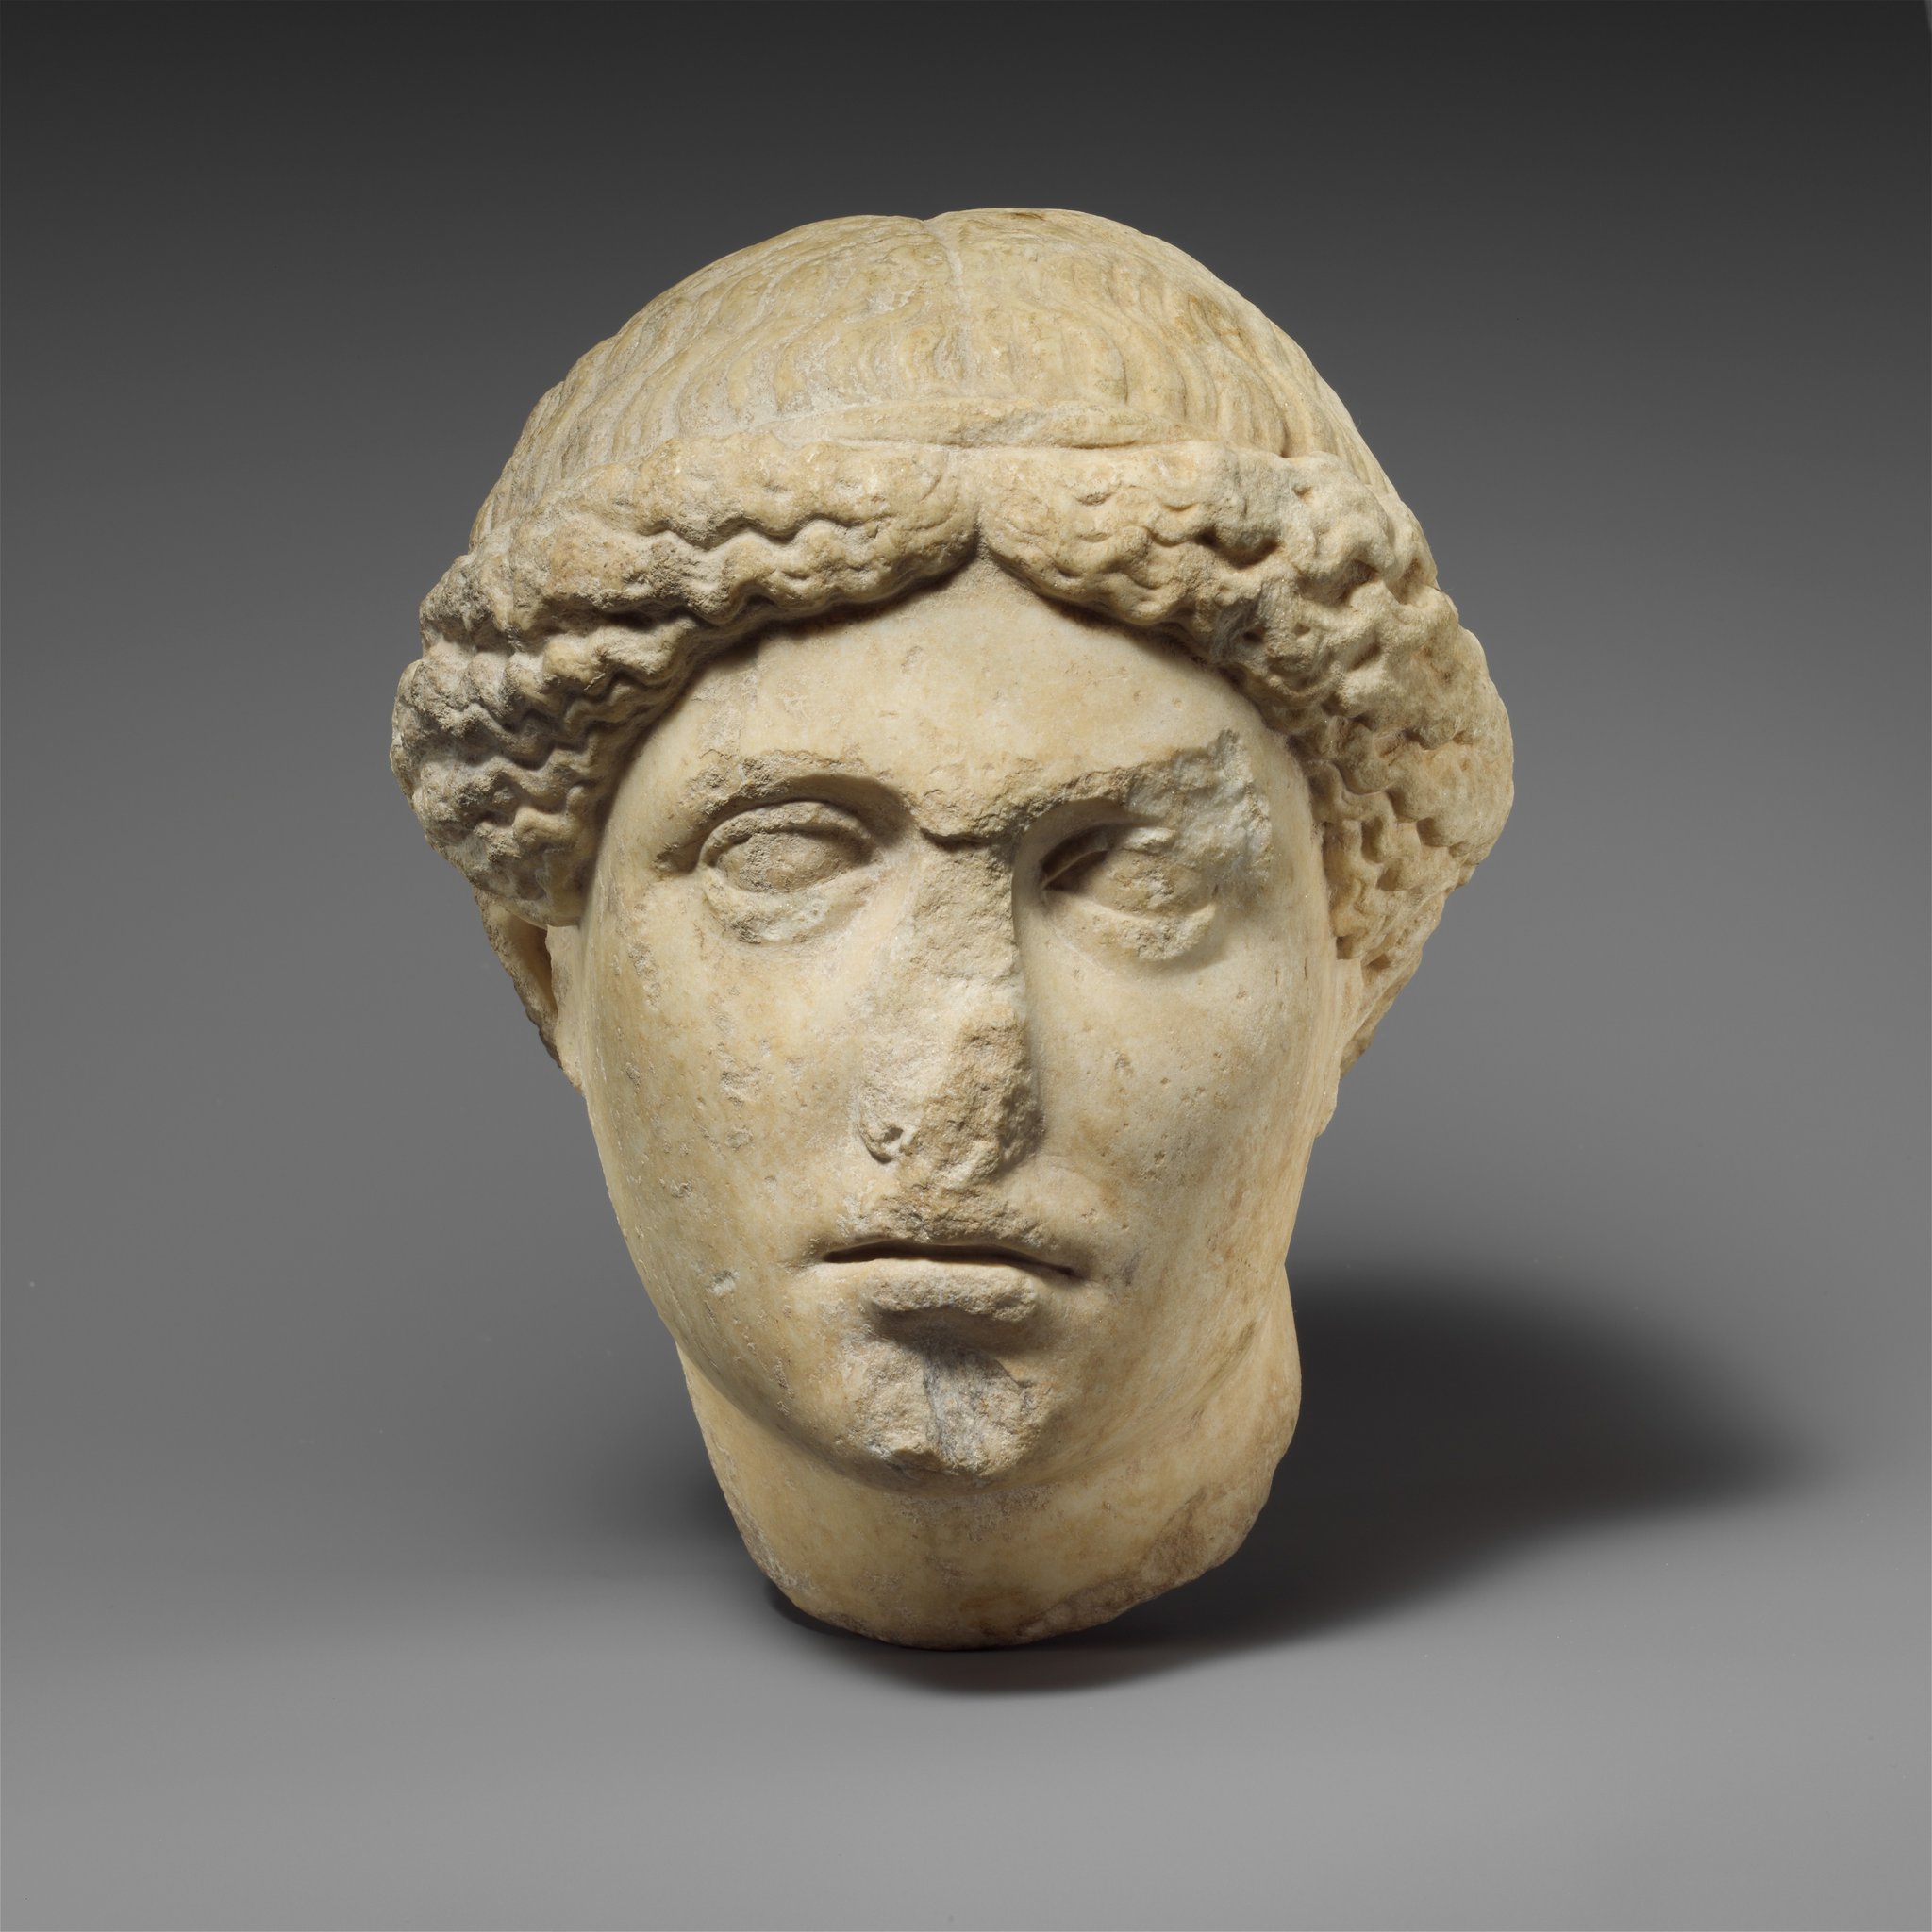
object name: head of a woman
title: Marble head of the so-called Barberini Suppliant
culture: roman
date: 1-100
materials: marble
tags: heads,men